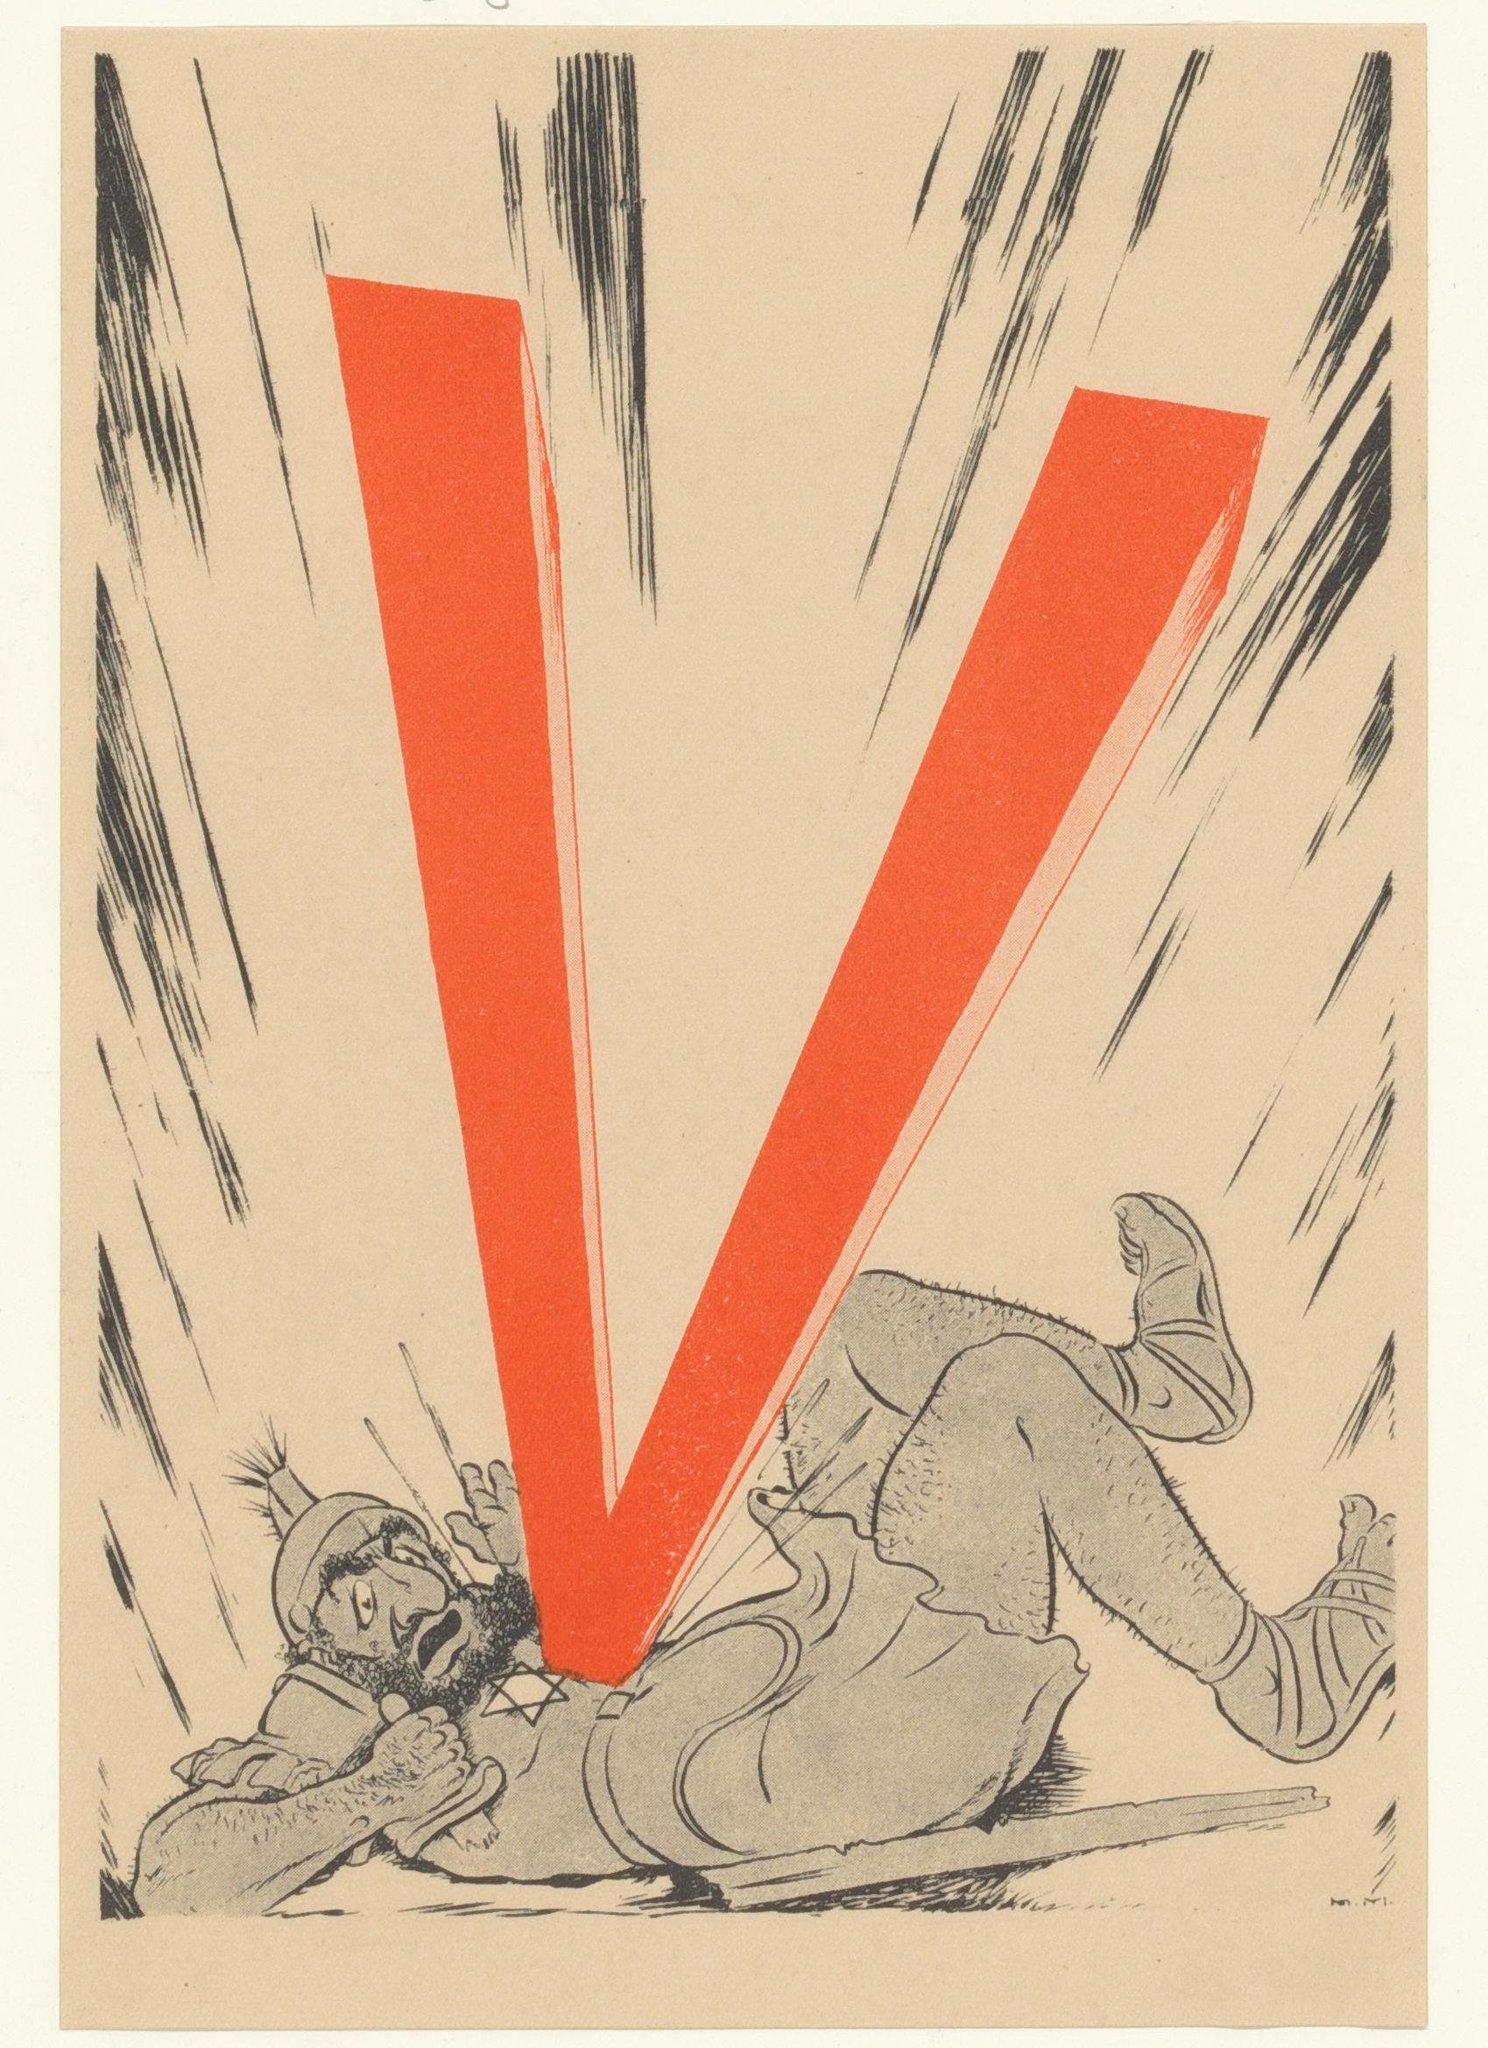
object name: photomechanical print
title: Anti-Joodse spotprent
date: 1941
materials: paper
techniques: autotype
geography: netherlands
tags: anti-semitism, political caricatures and satires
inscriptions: collector's mark, collector's mark: Lugt 1641